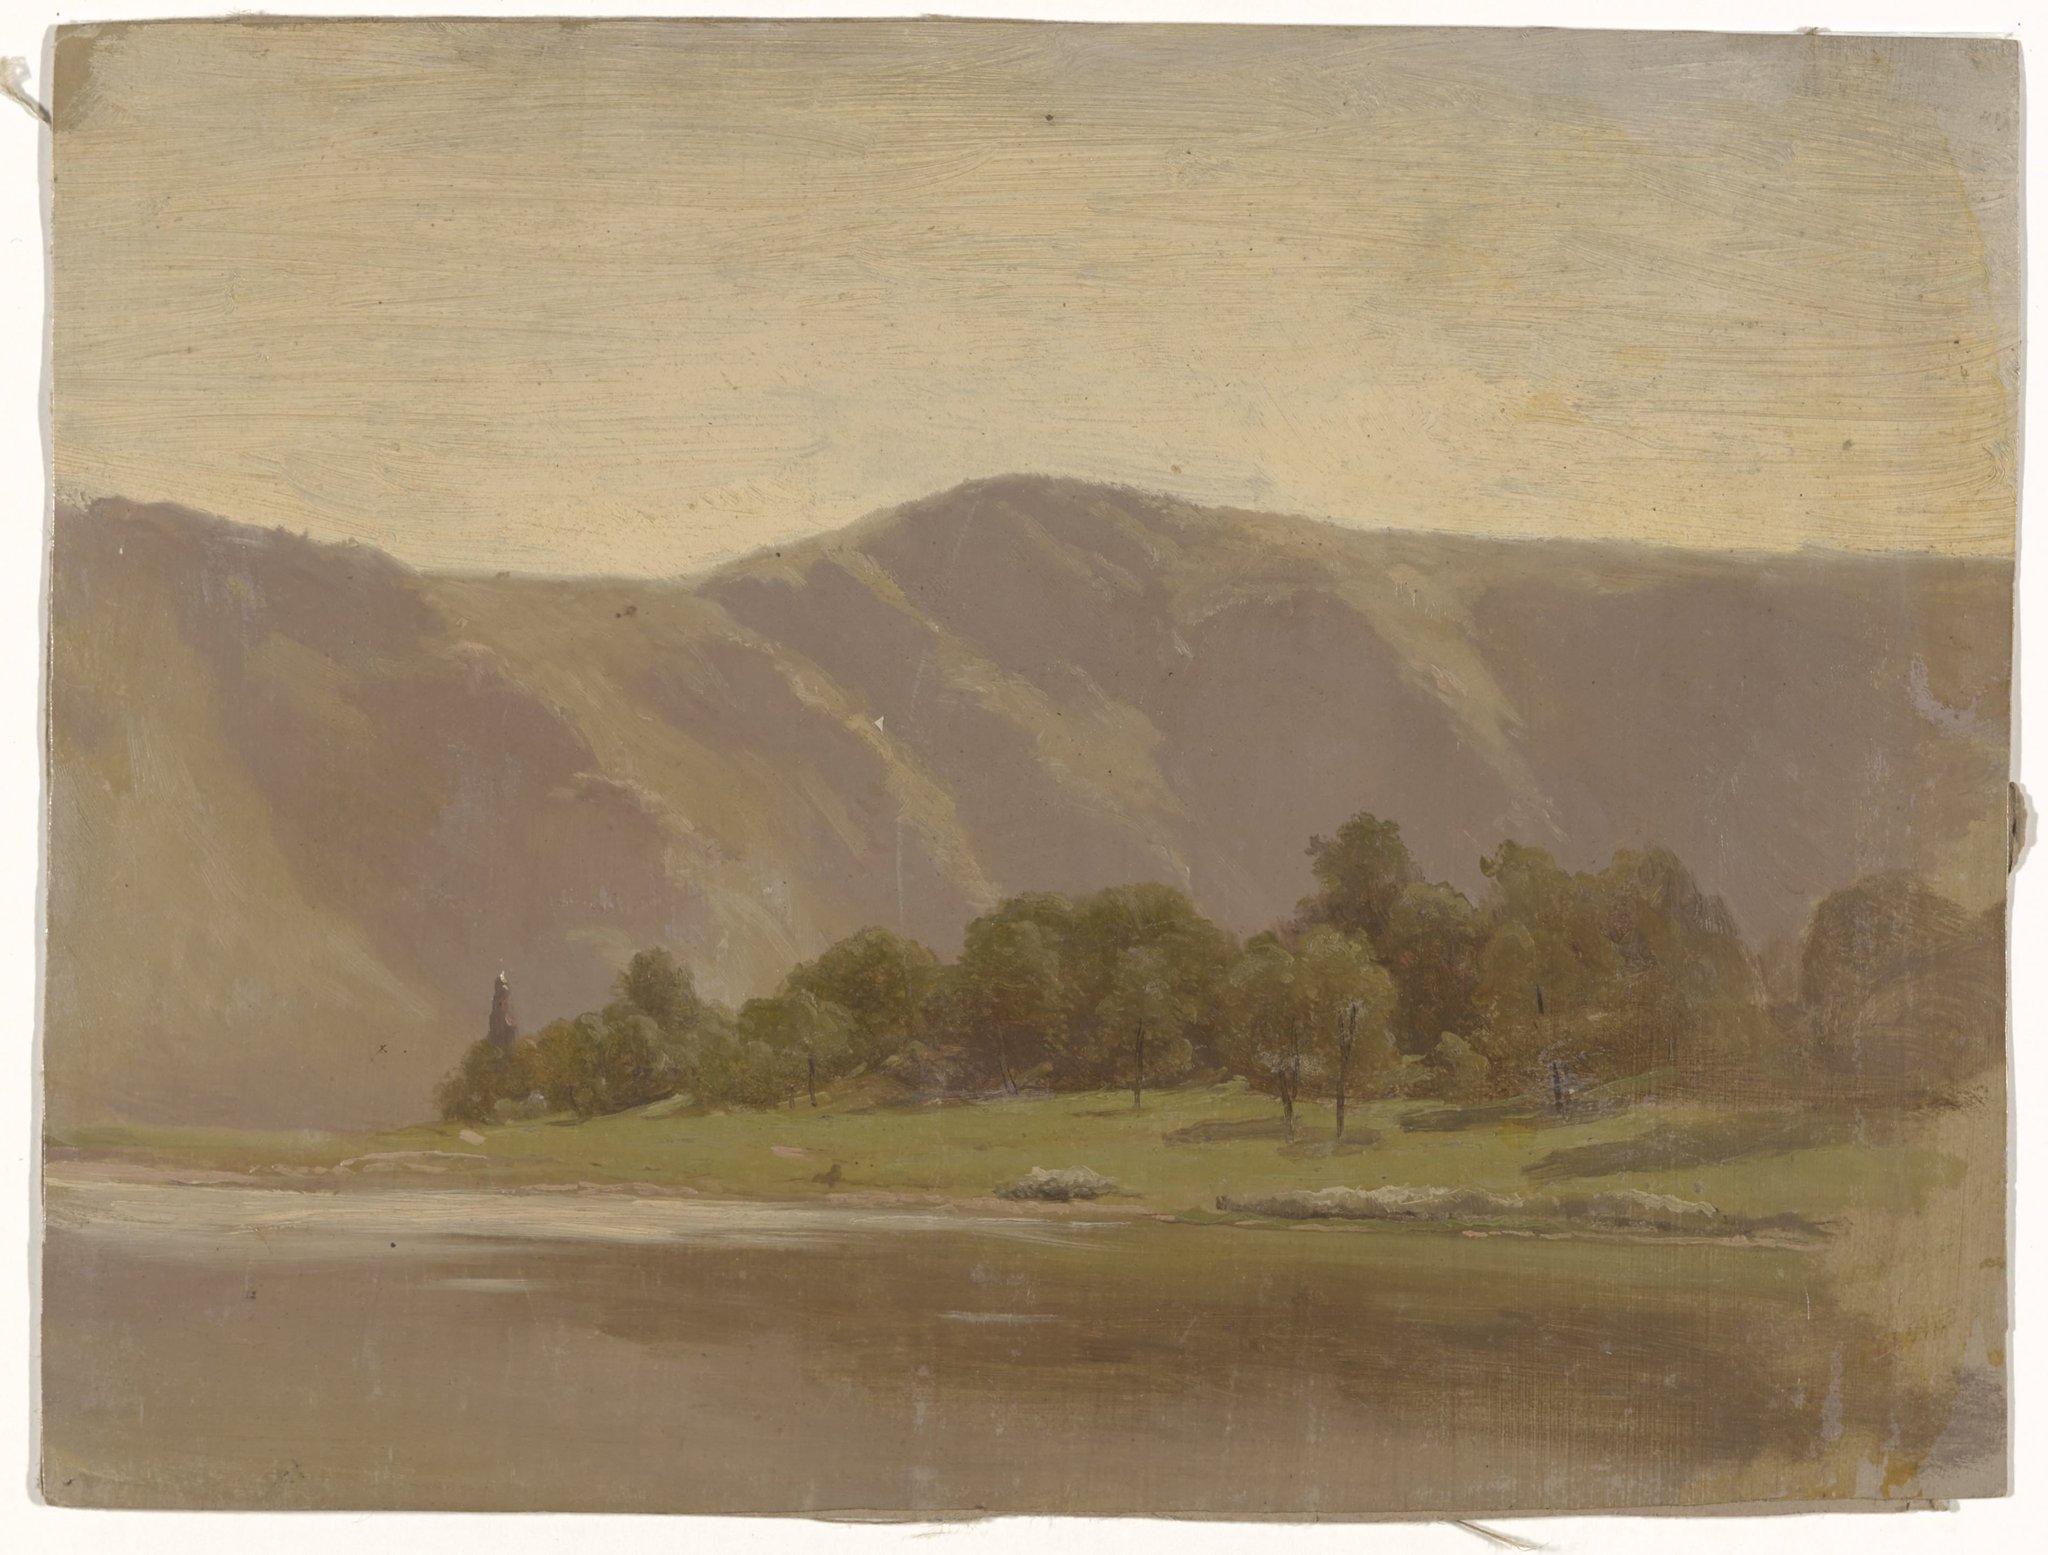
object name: drawing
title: Rivier aan de voet van een gebergte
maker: guillaume anne van der brugghen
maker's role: draughtsman, print maker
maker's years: 1812-1891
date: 1821-1891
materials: cardboard, oil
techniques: brush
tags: river, mountains